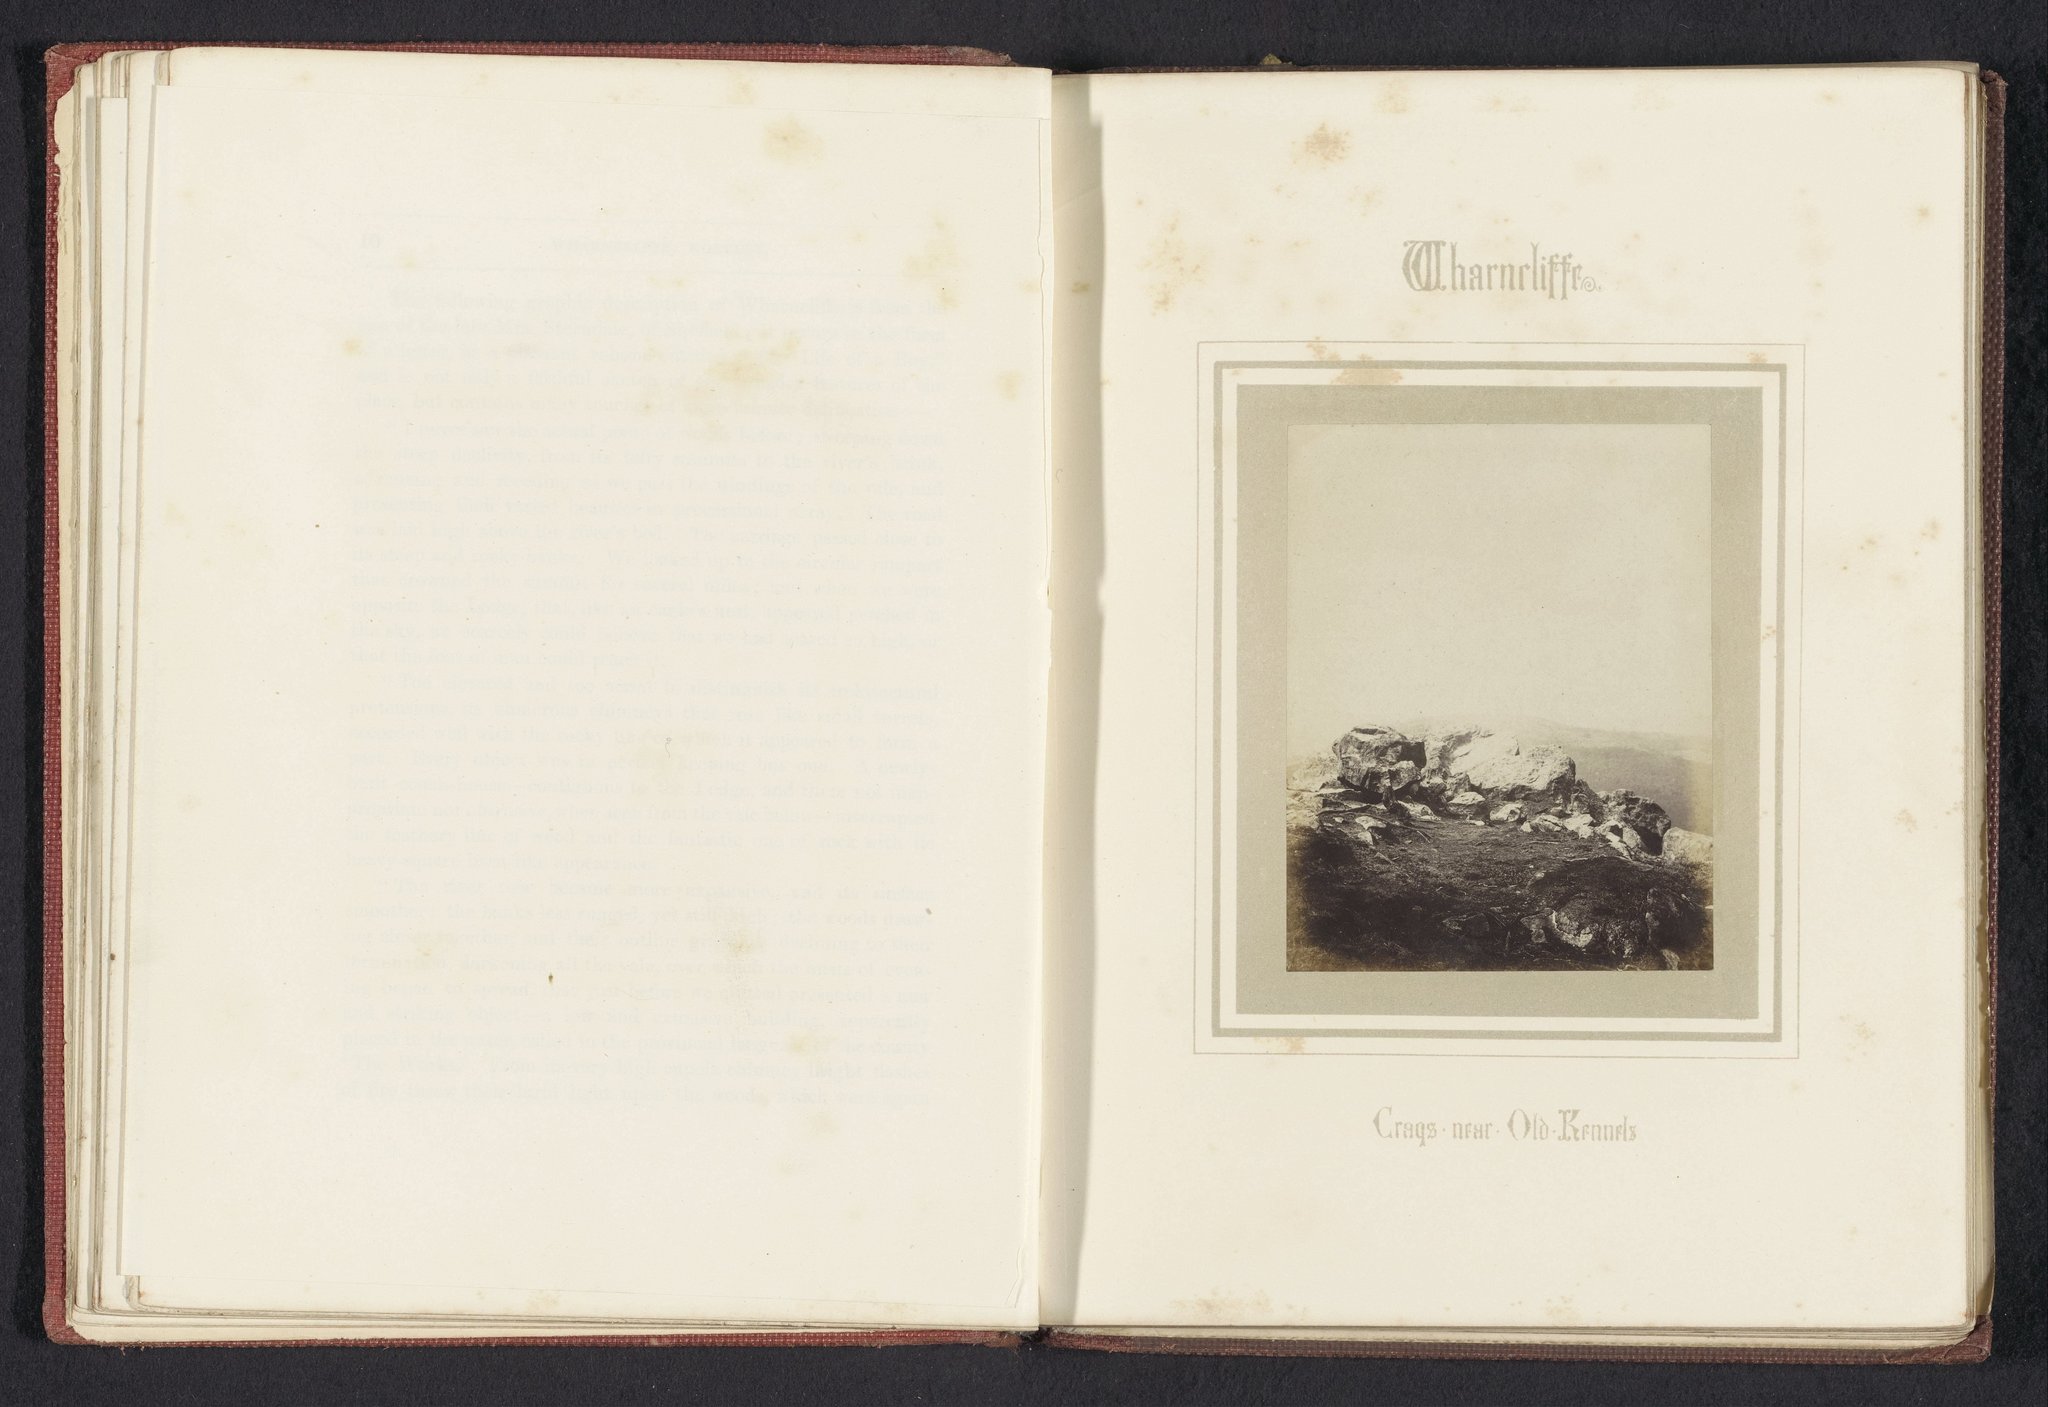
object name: page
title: Crags near Old Kennels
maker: theophilus smith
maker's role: fotograaf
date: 1854-1864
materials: photographic support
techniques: albumen print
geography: wharncliffe crags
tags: rock-formations